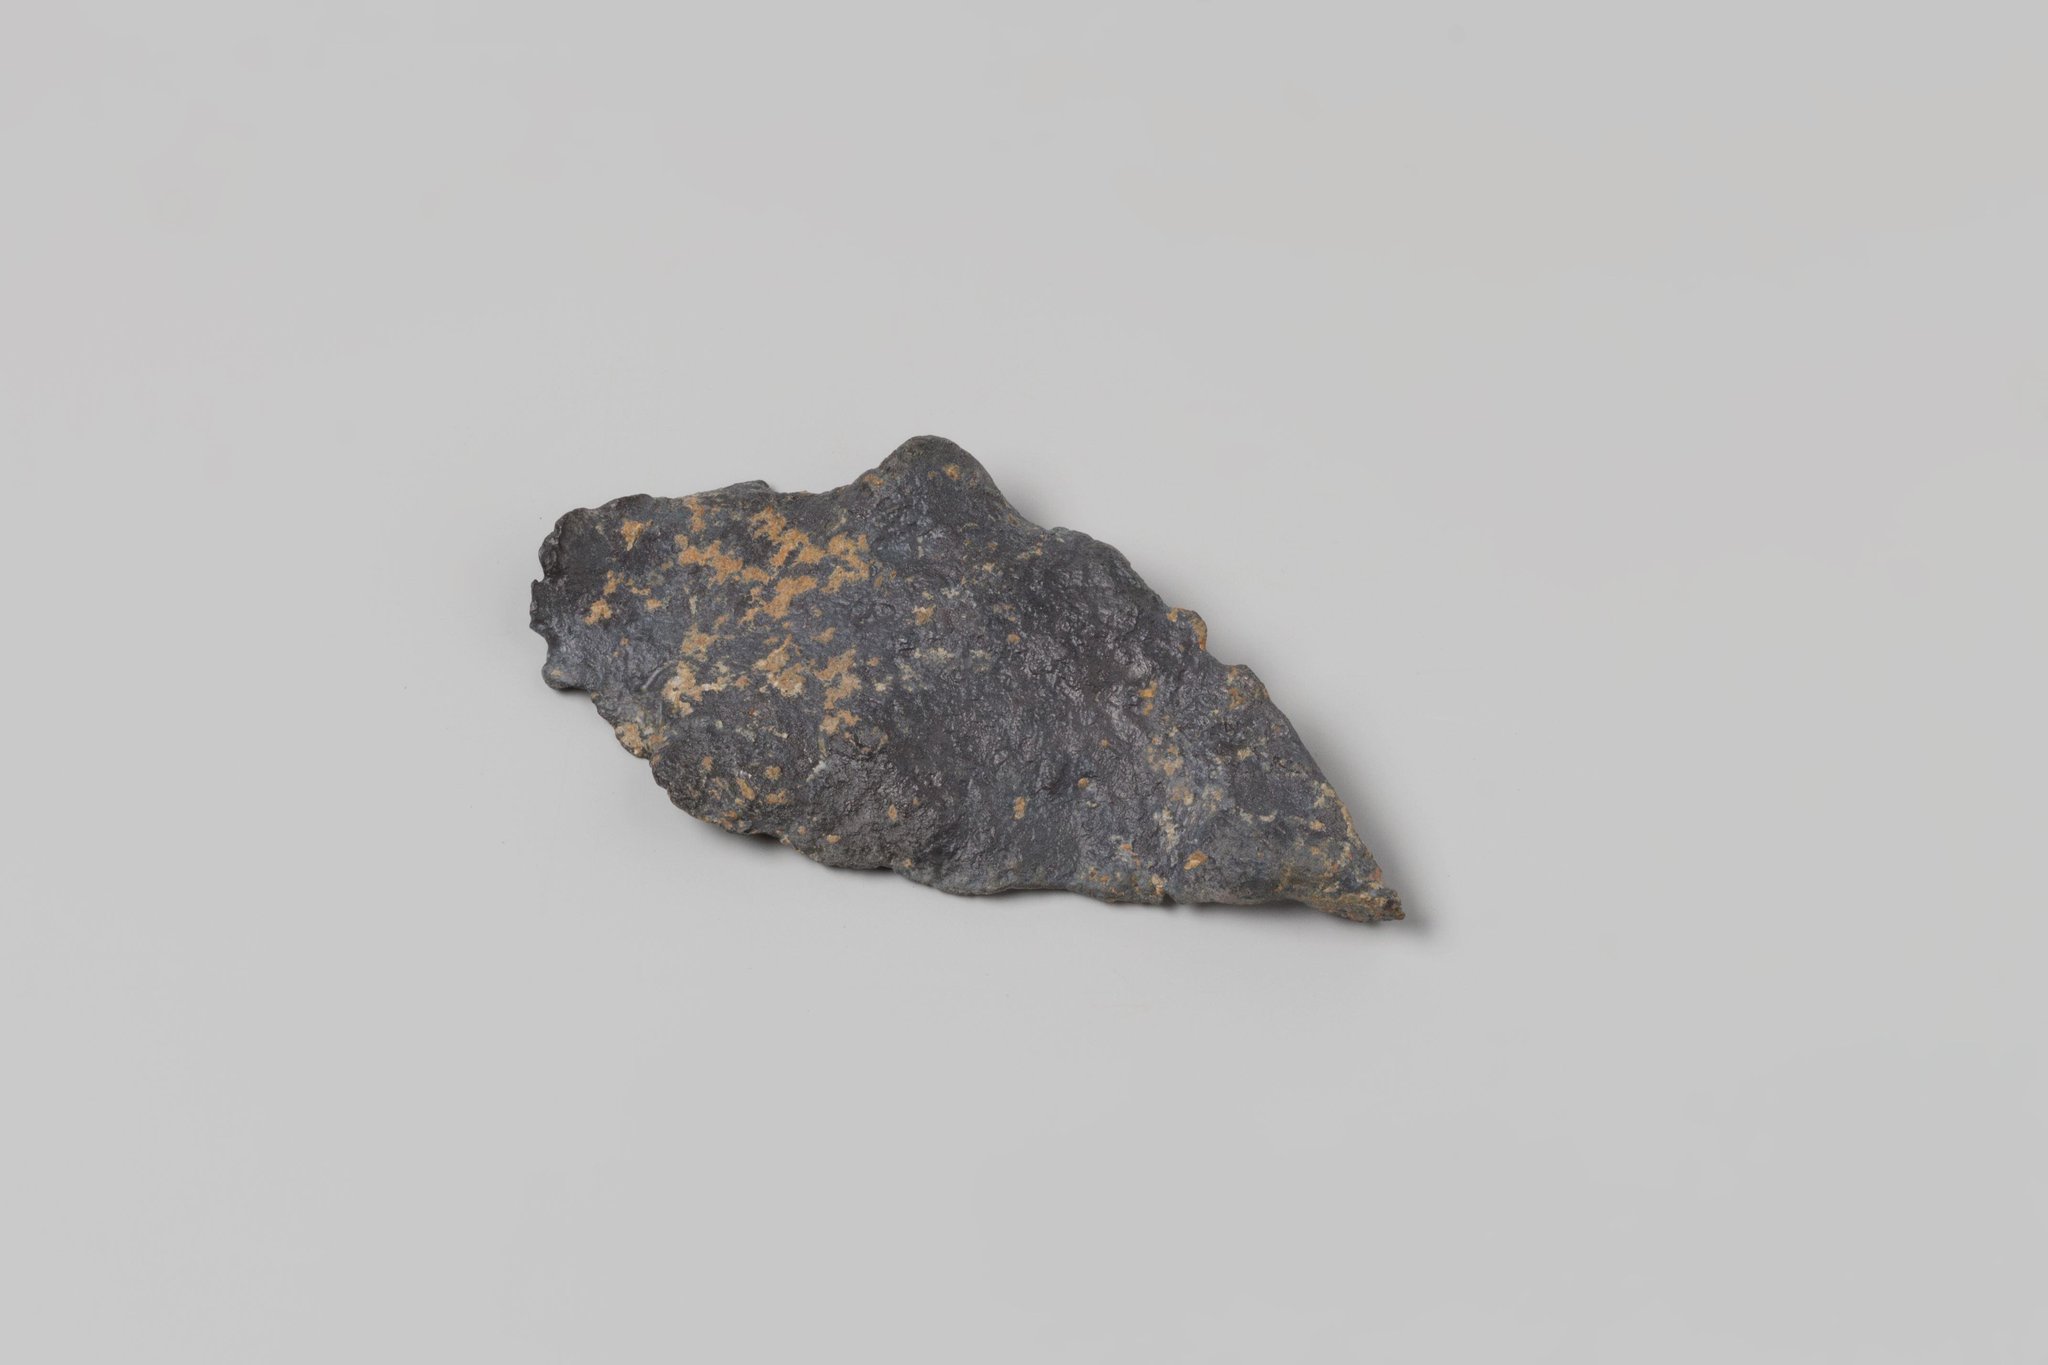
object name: fragment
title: Fragment lood uit het wrak van de Oost-Indiëvaarder Hollandia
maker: Anonymous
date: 1700-1743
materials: lead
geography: netherlands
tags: verenigde oostindische compagnie, hollandia (schip), annet